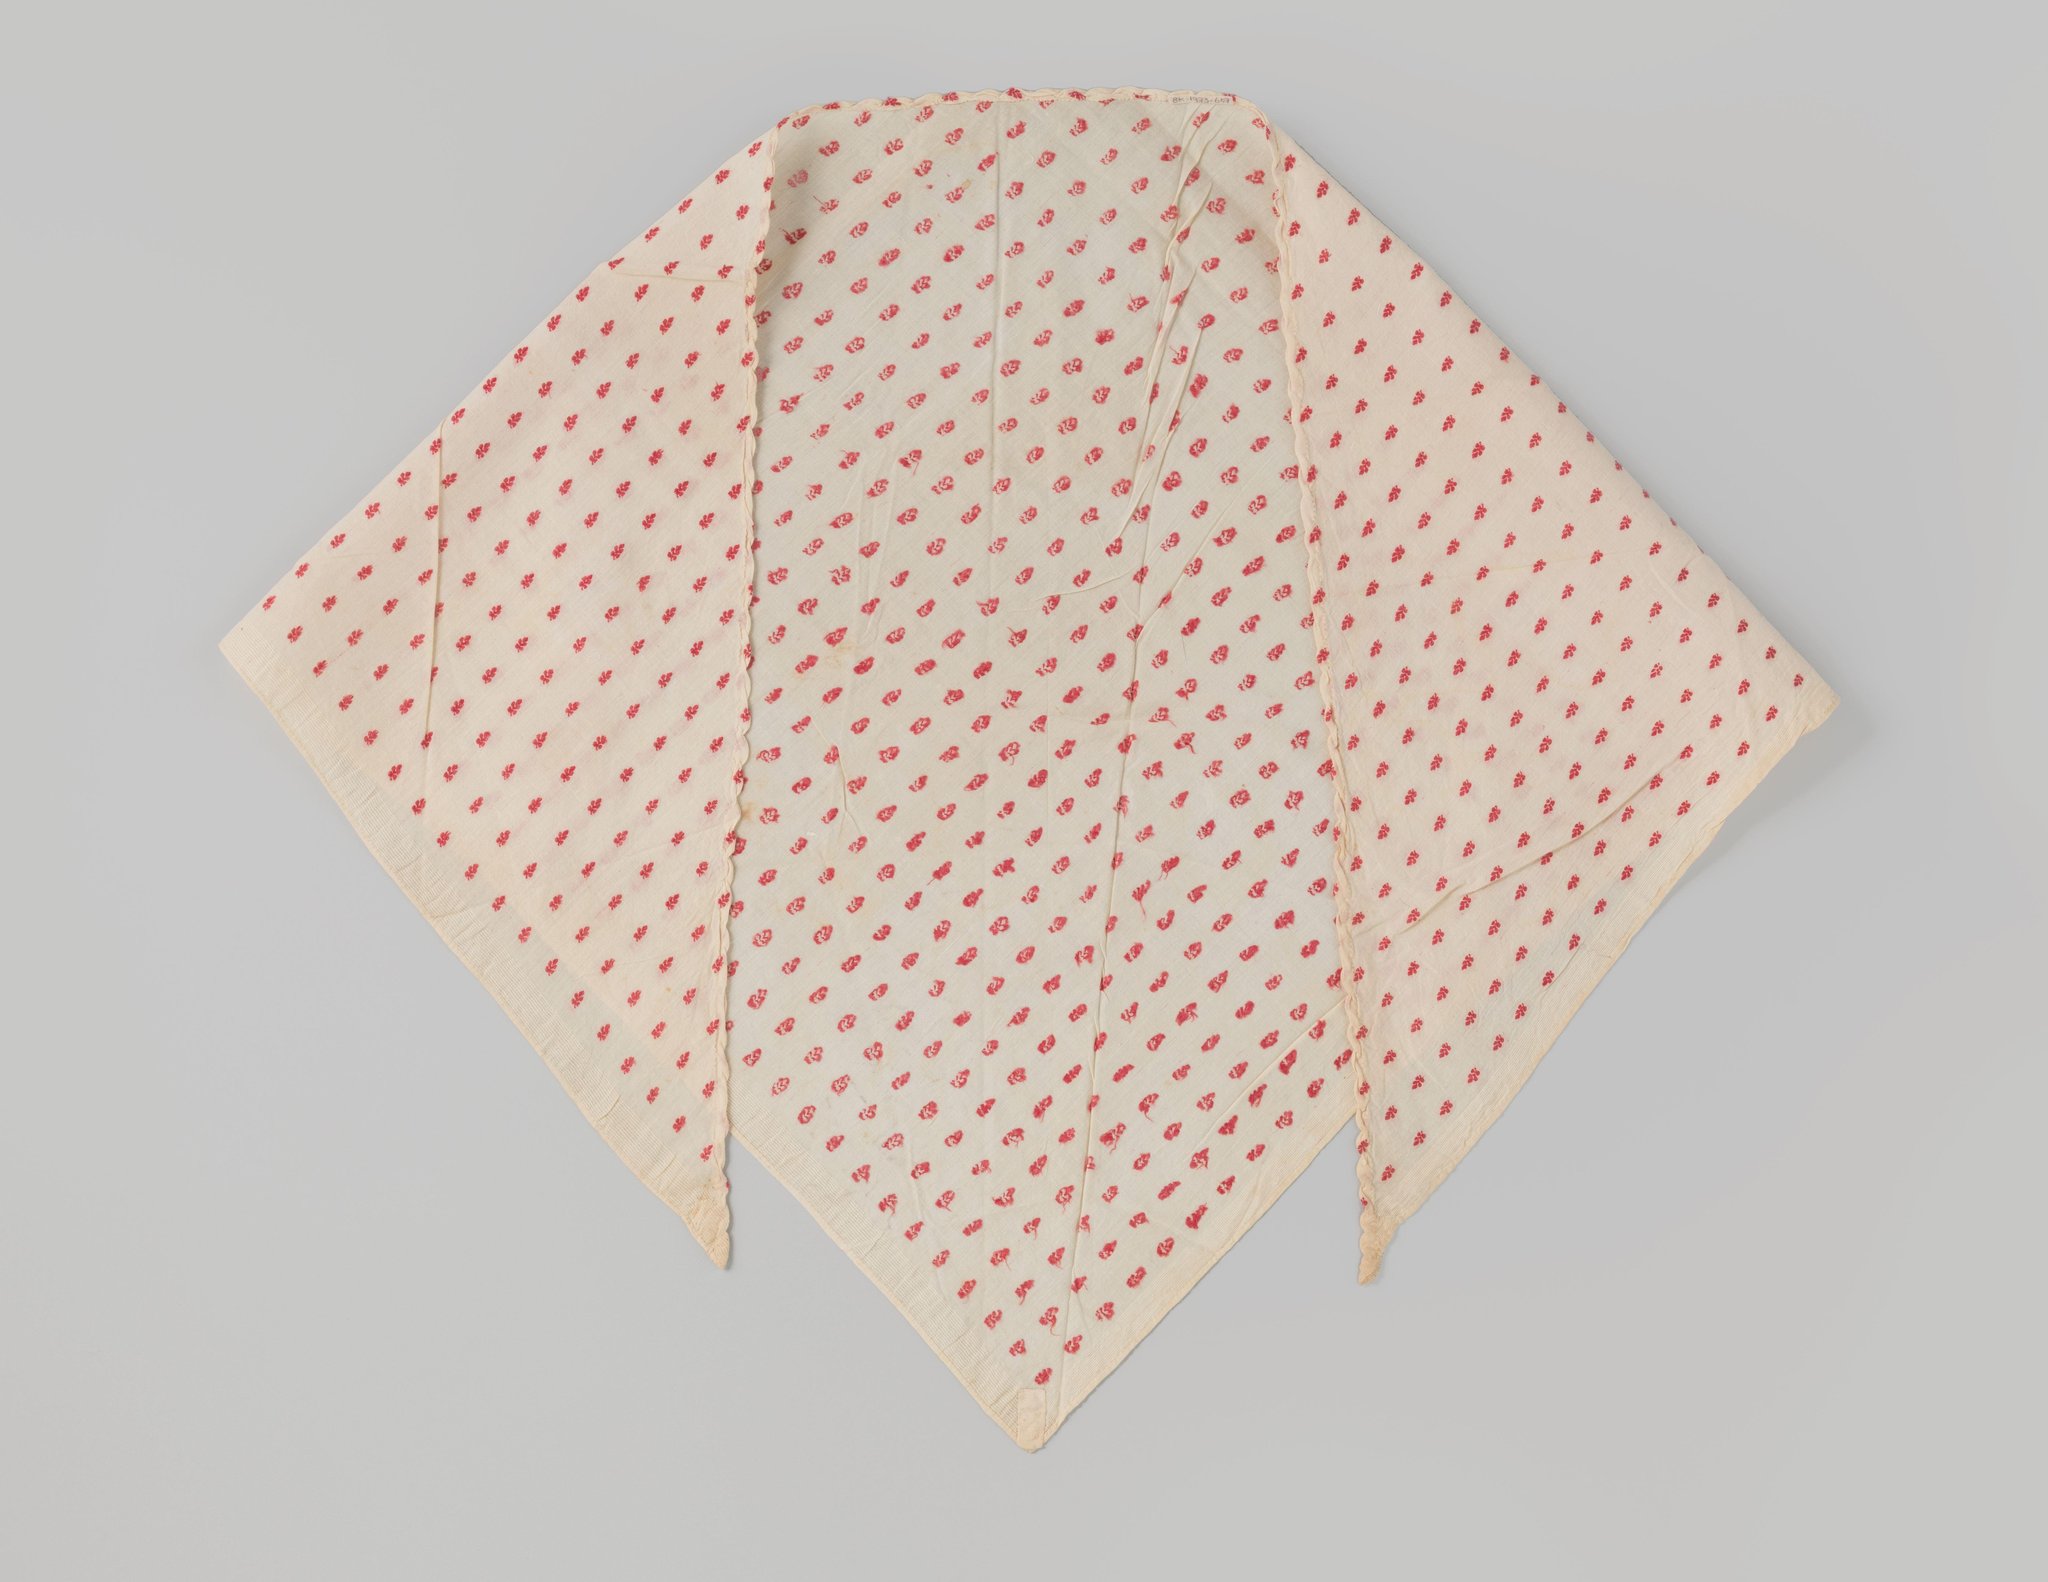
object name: womenswear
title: Fichu, driehoekig, van linnen met een ingeweven rood strooipatroon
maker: Anonymous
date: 1800-1900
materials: linen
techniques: weave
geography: friesland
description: Driehoekige fichu van linnen met een ingeweven rood strooipatroon.